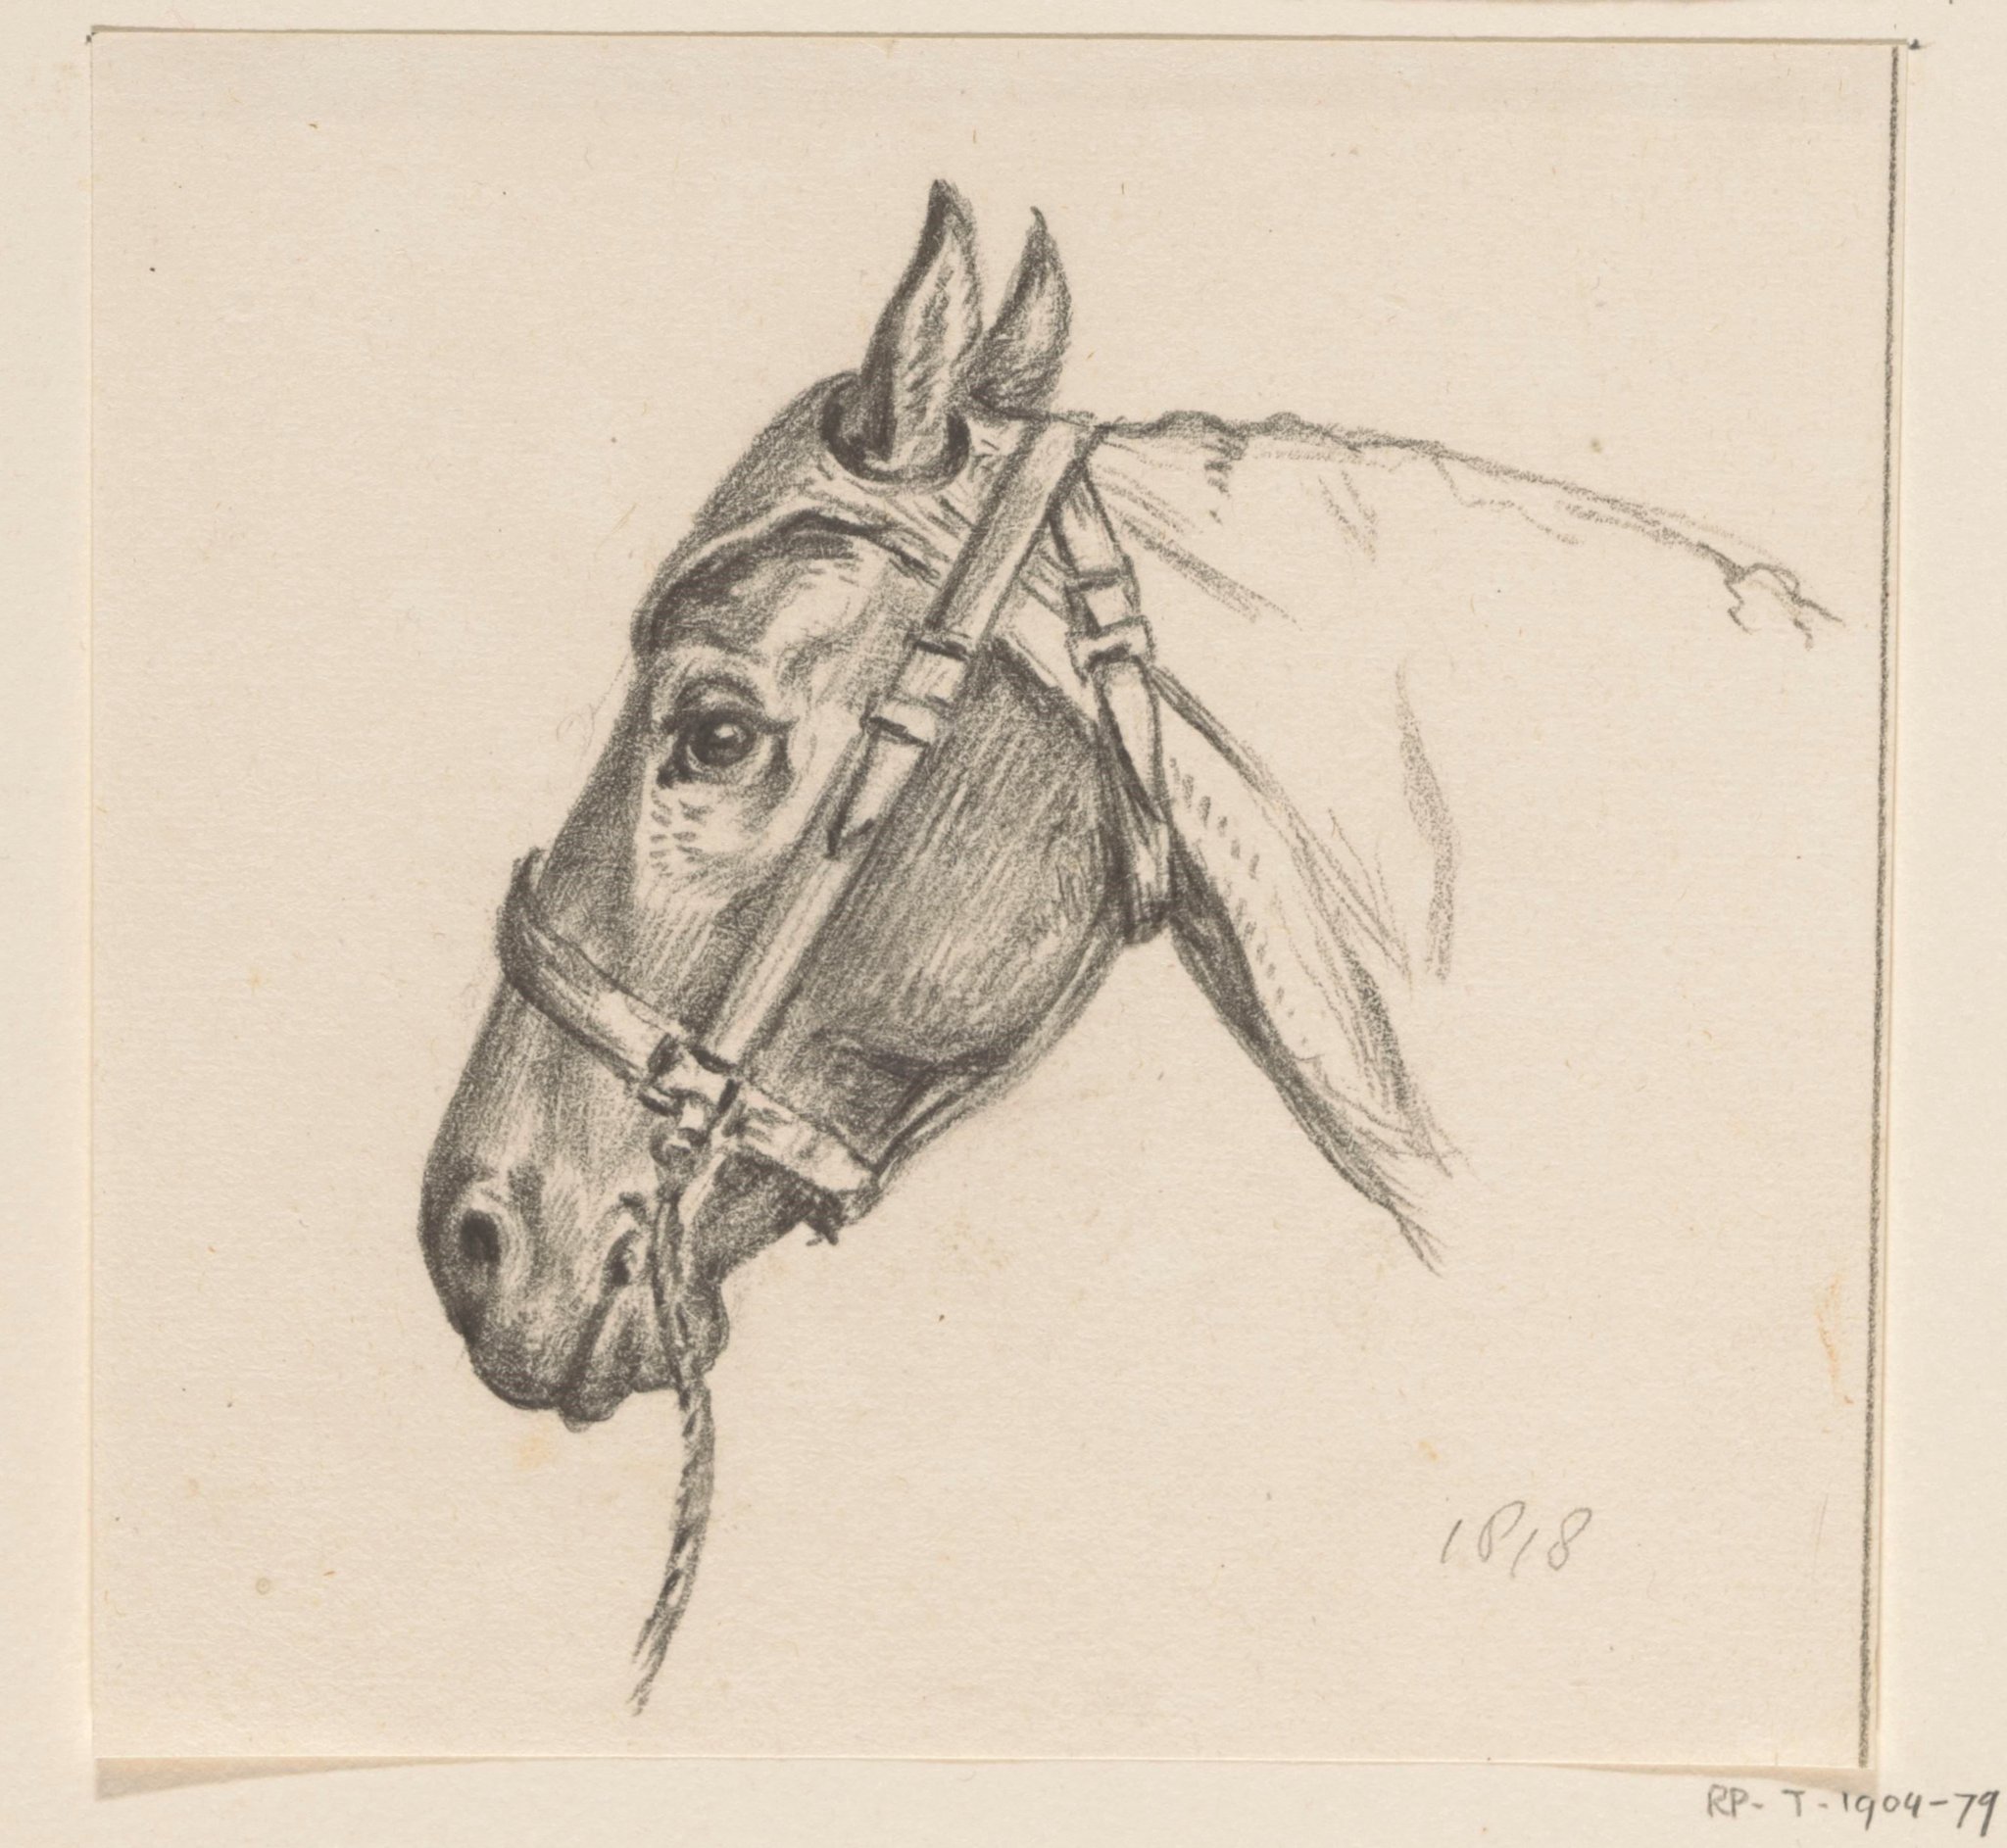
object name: drawing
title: Hoofd van een paard met een kap op, naar links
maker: jean bernard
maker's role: draughtsman, print maker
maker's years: 1765-1833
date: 1818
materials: chalk, paper, pencil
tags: horse